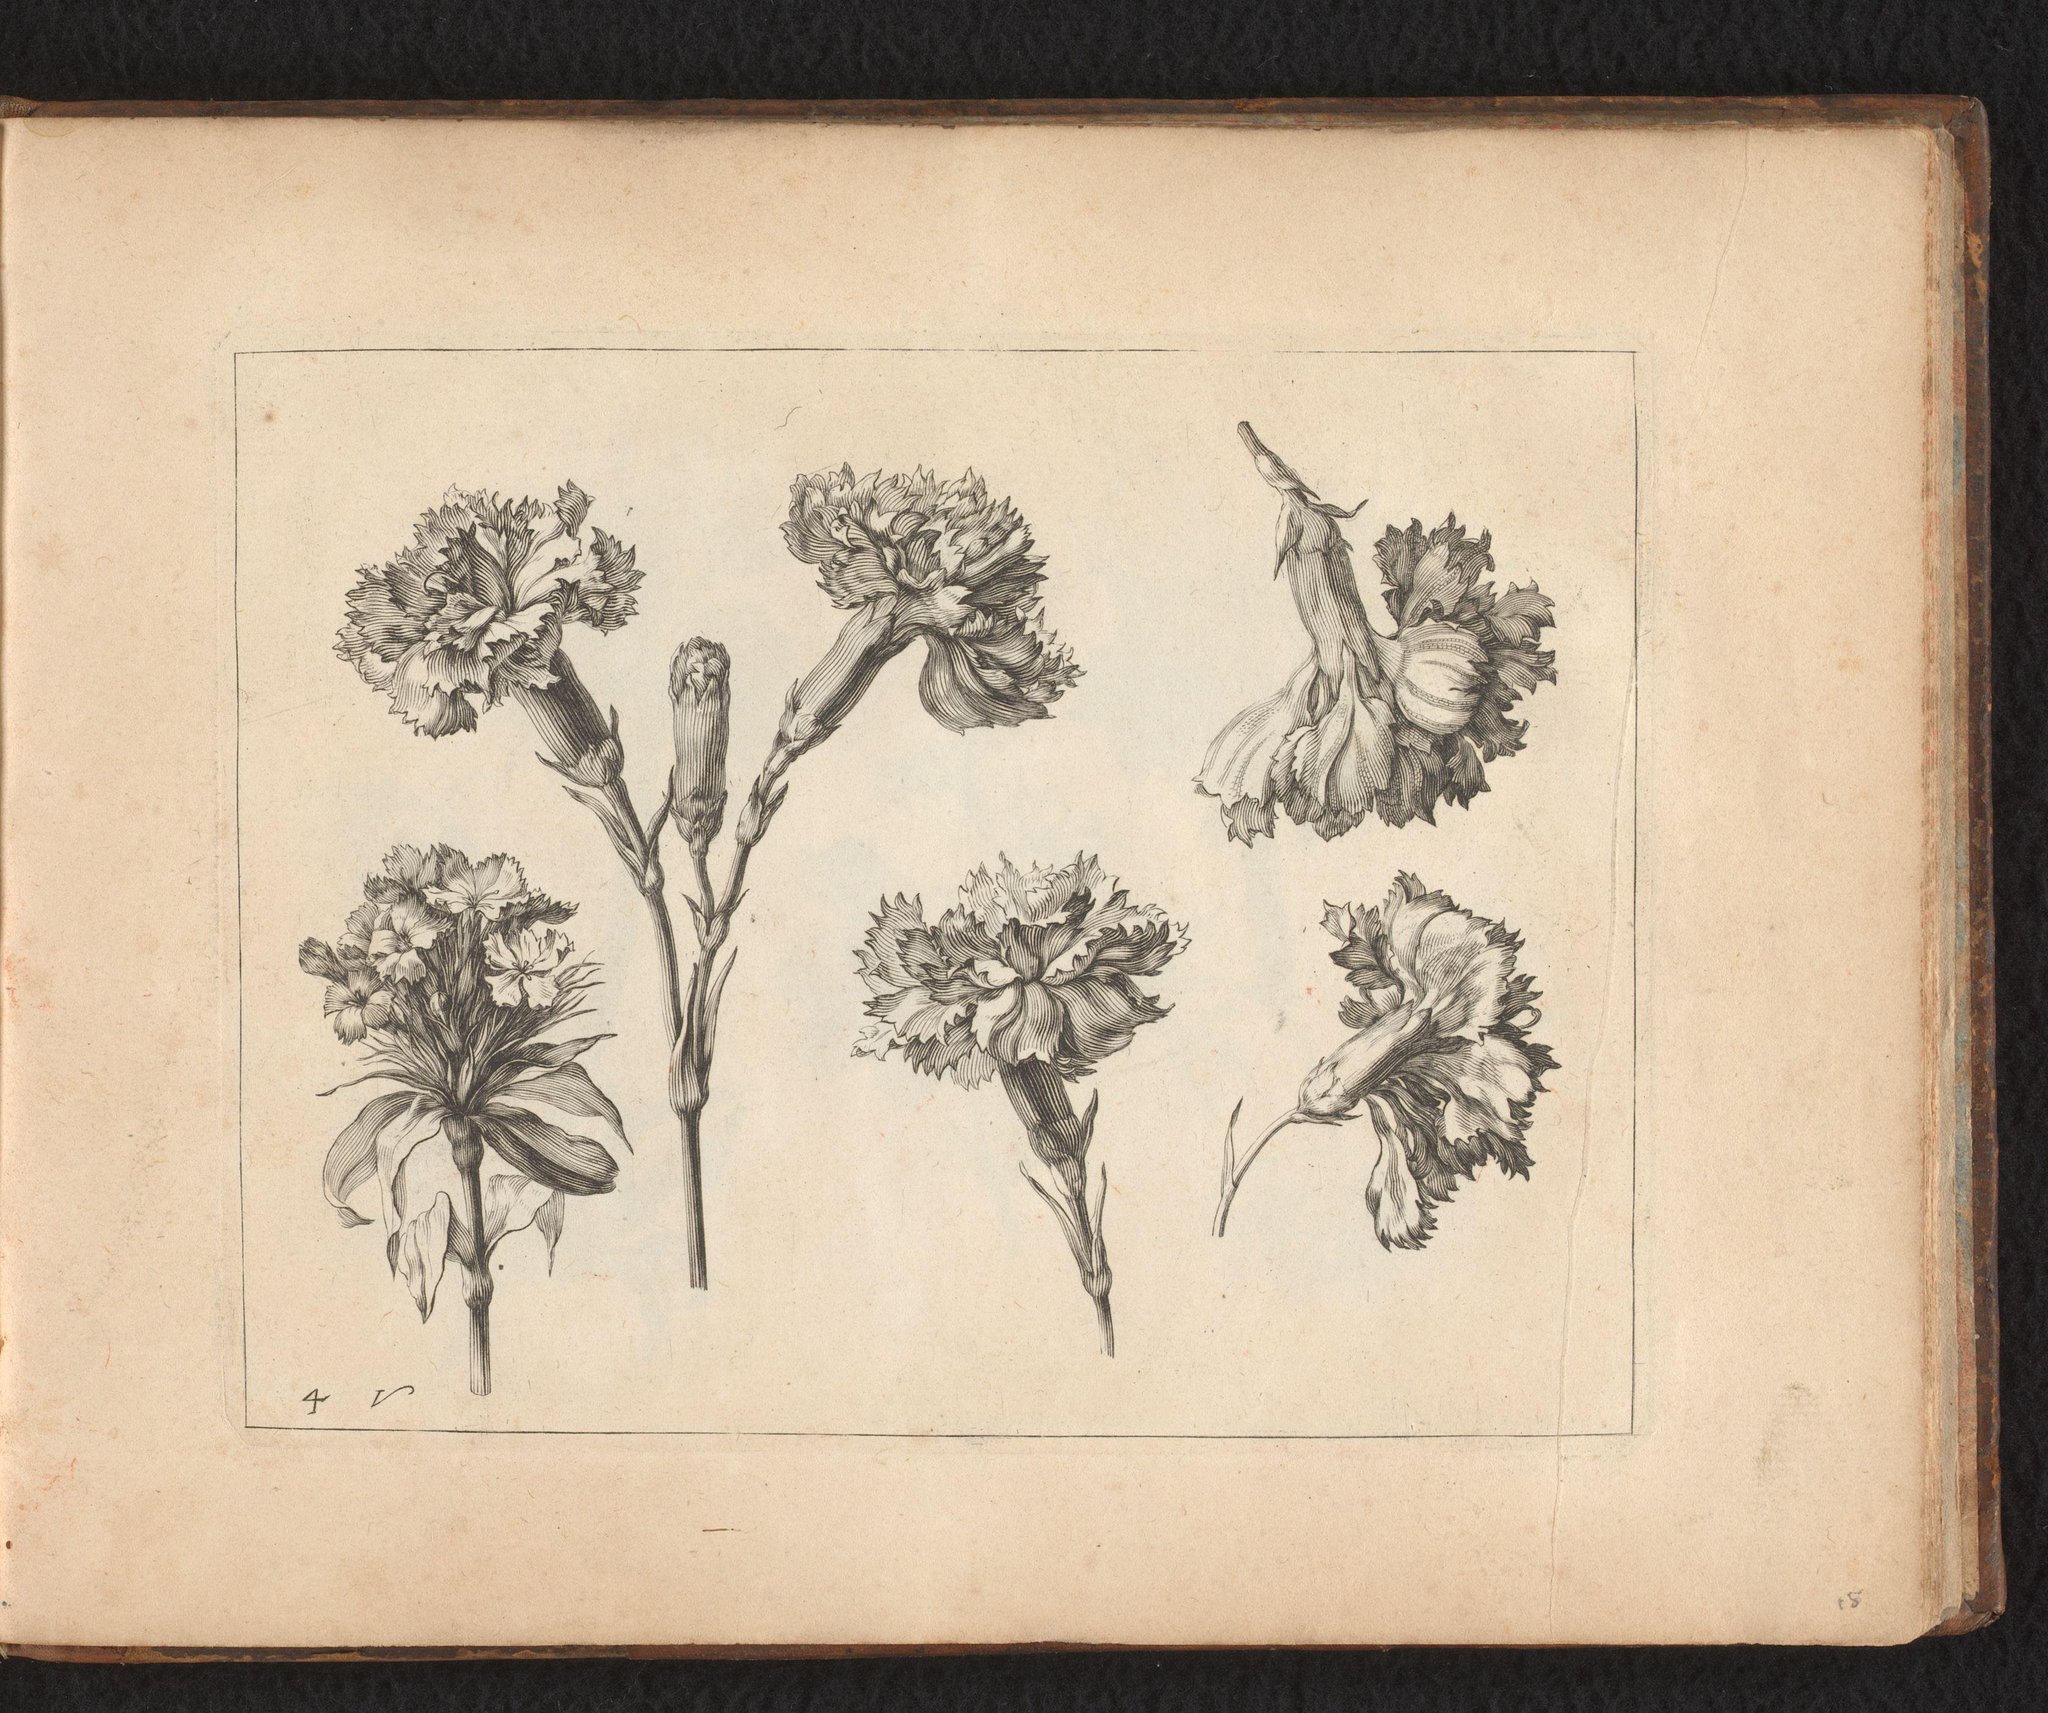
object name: album leaf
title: Bloeiwijze van anjer en details van de plant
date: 1650-1676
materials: paper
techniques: engraving, etching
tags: flowers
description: Deze prent maakt deel uit van een album.